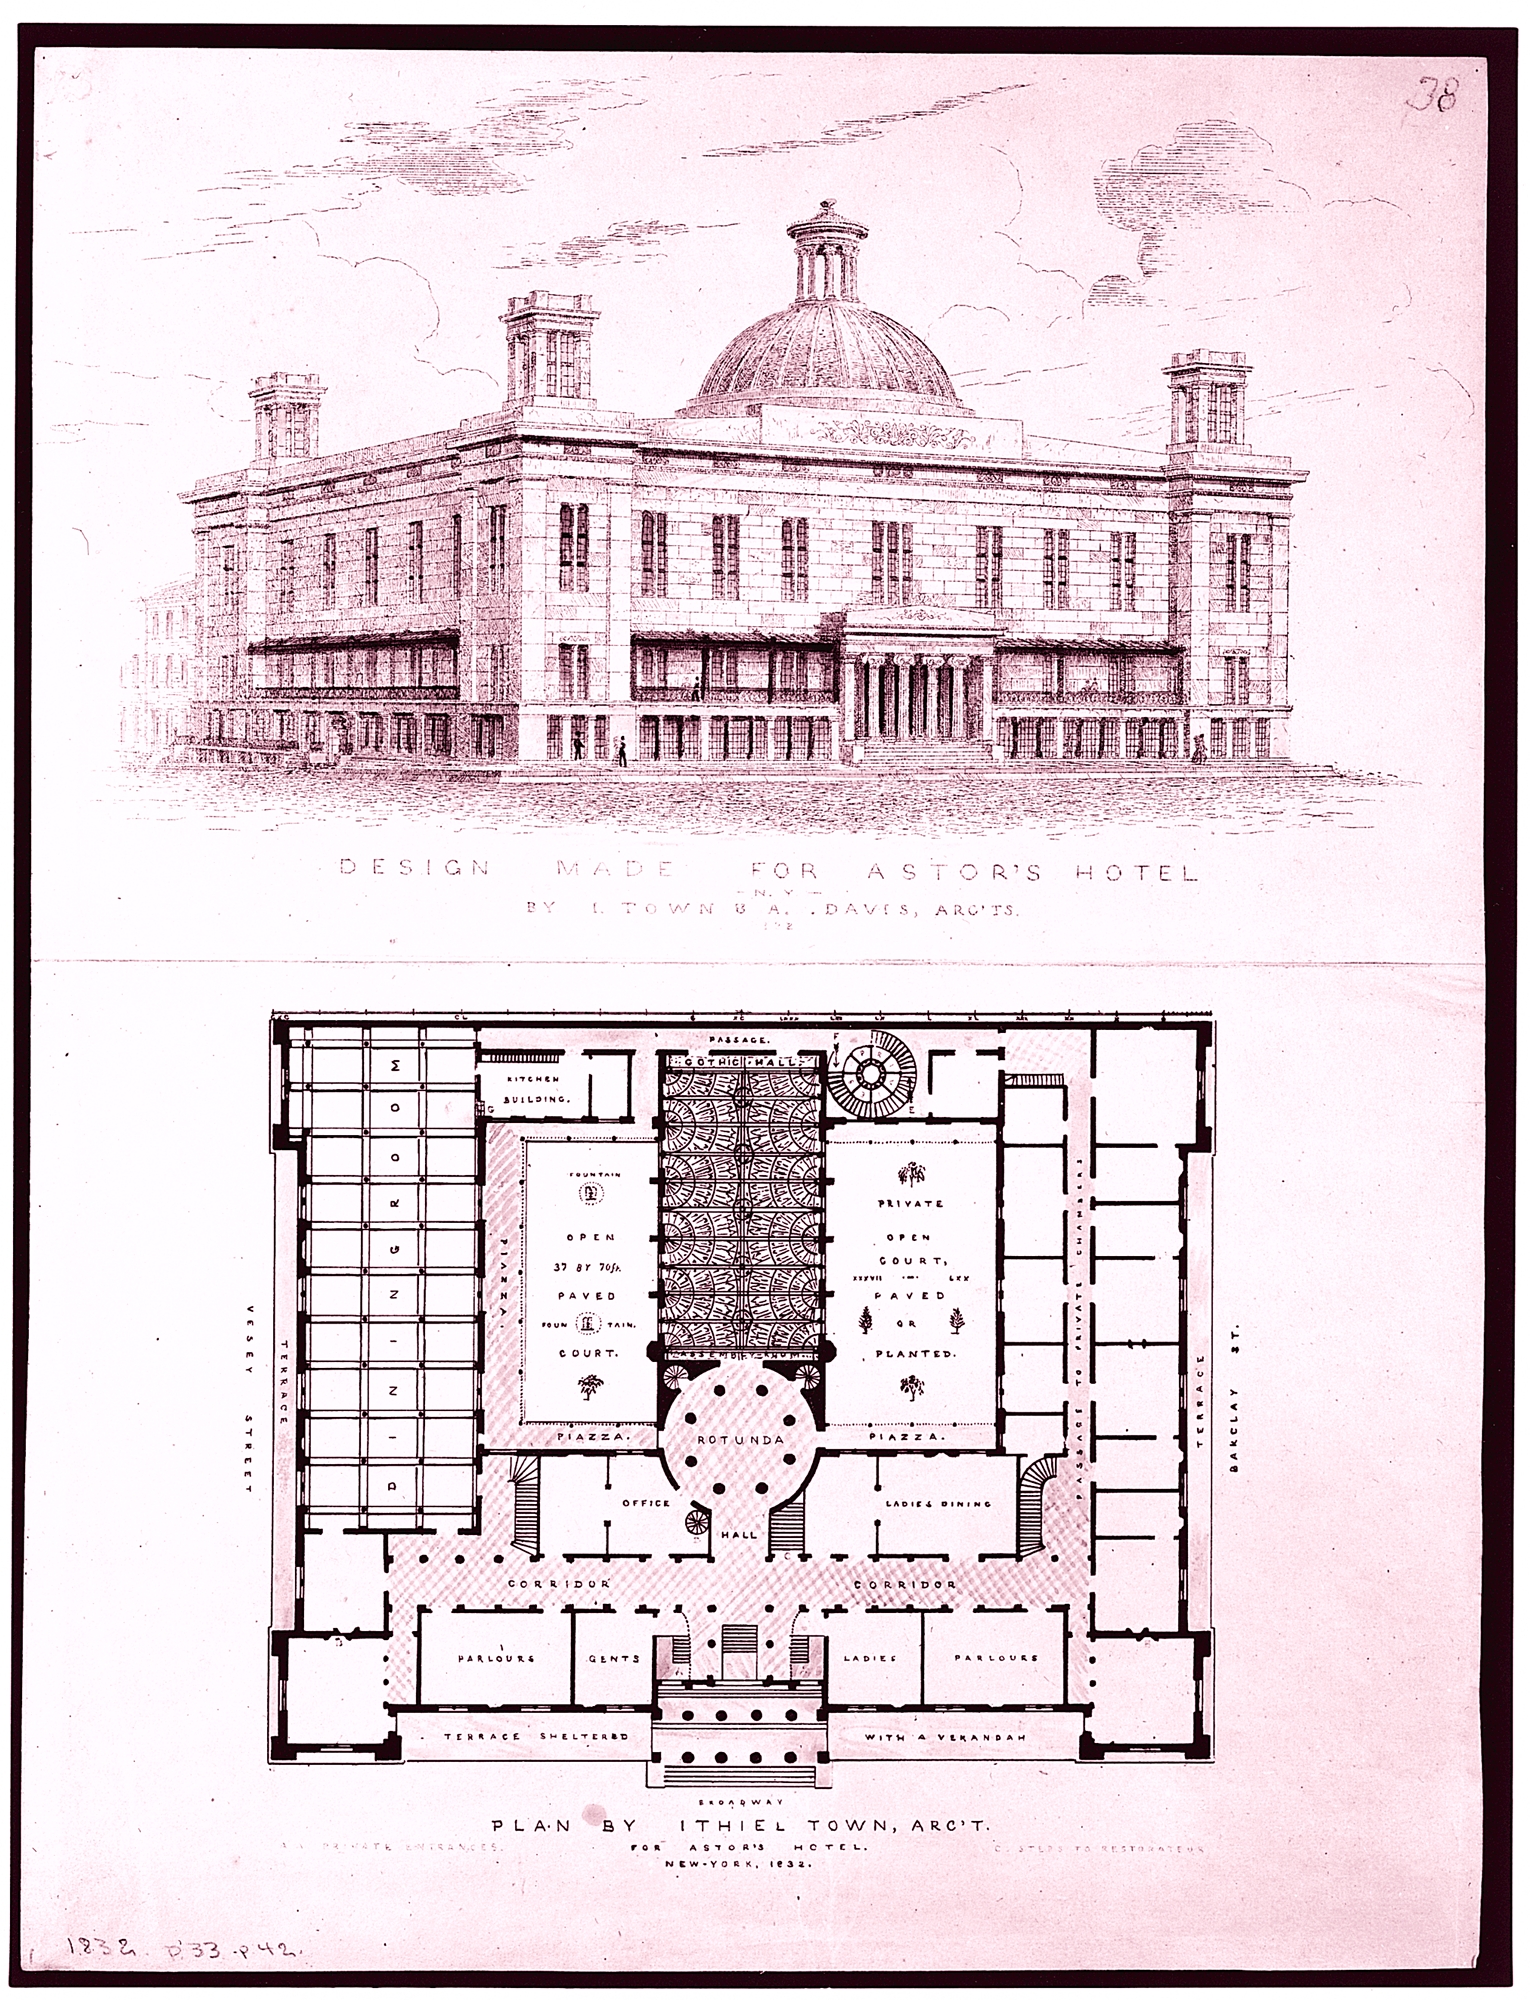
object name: print ornament architecture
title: Design for Astor's Hotel, New York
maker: alexander jackson davis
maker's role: artist and architect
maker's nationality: american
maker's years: 1803-1892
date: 1834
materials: watercolor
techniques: lithograph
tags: architecture,hotels